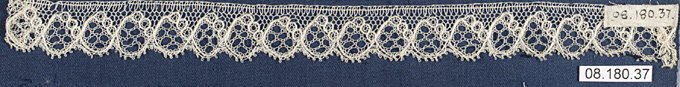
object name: fragment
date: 1801-1900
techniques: lace